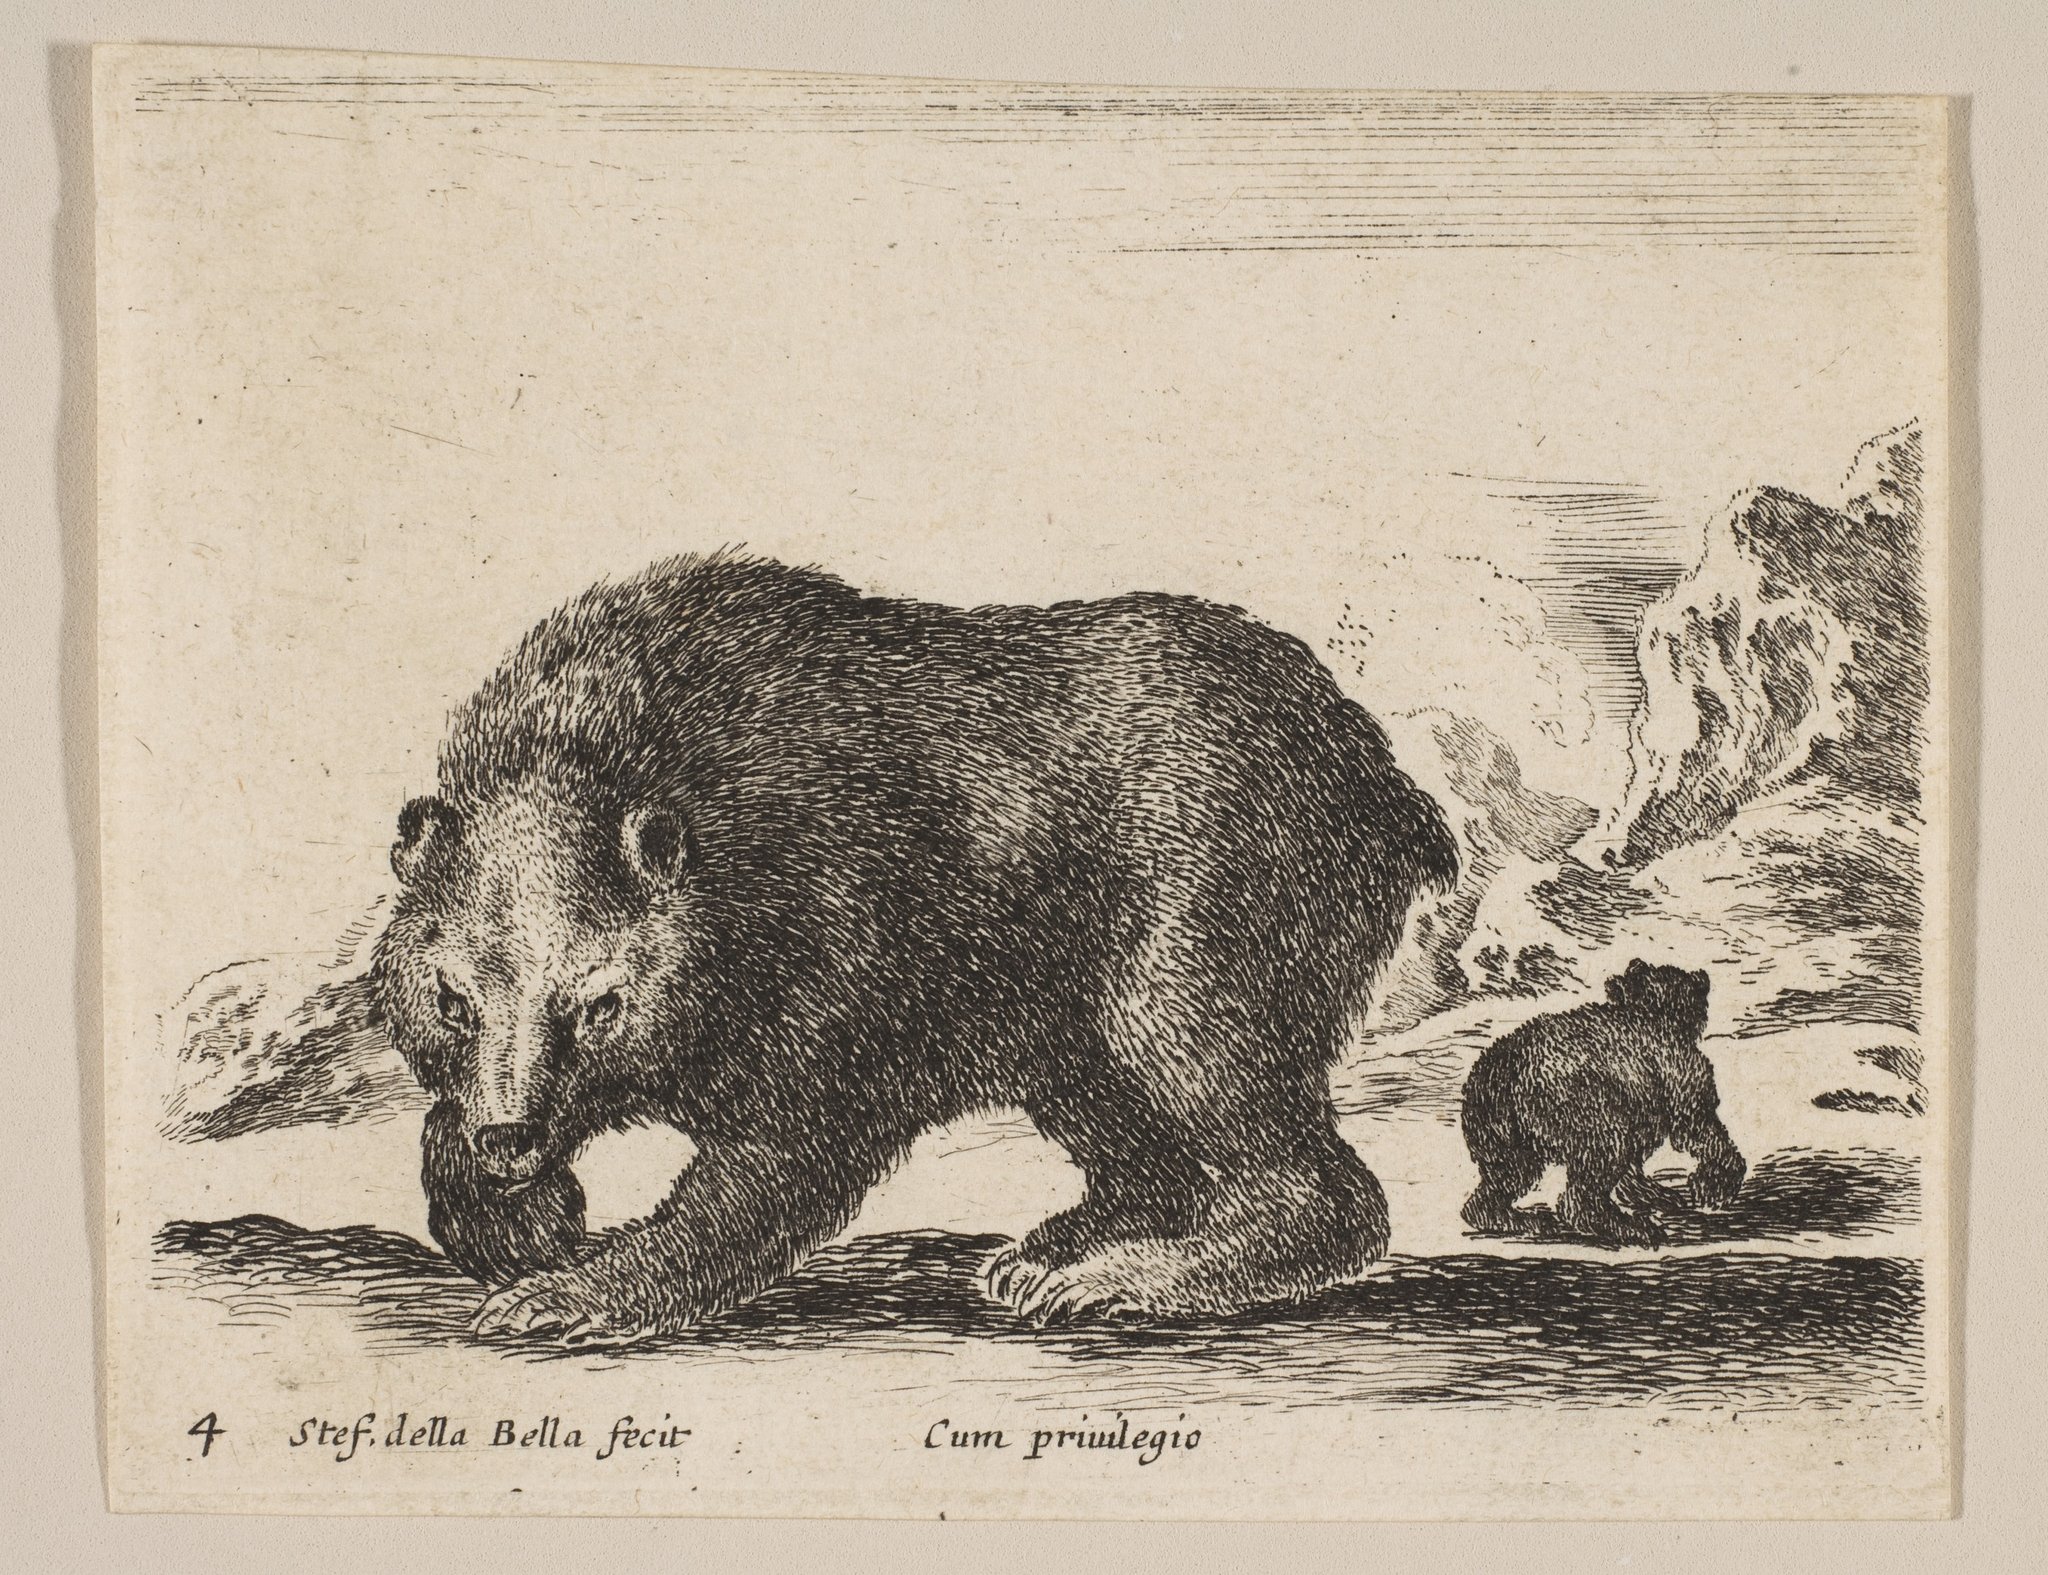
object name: print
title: Plate 4: Bear, from "Various animals" (Diversi animali)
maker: stefano della bella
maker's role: artist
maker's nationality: italian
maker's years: 1610-1664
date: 1641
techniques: etching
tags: bears